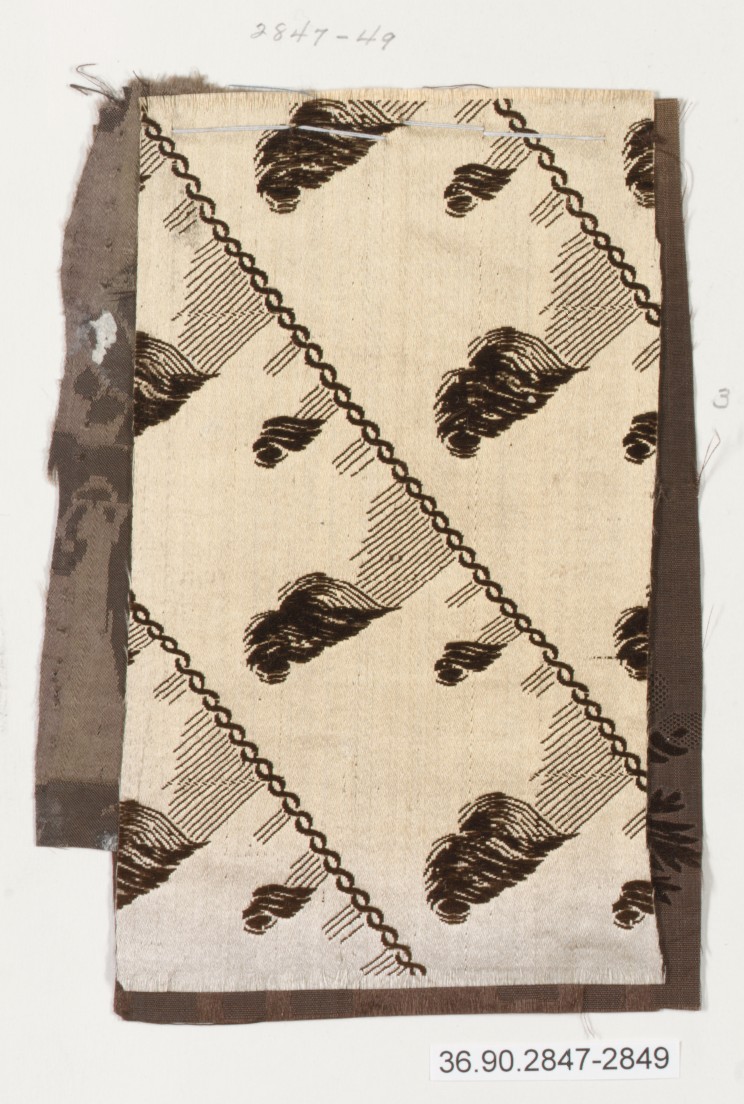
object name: piece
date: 1801-1900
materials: silk